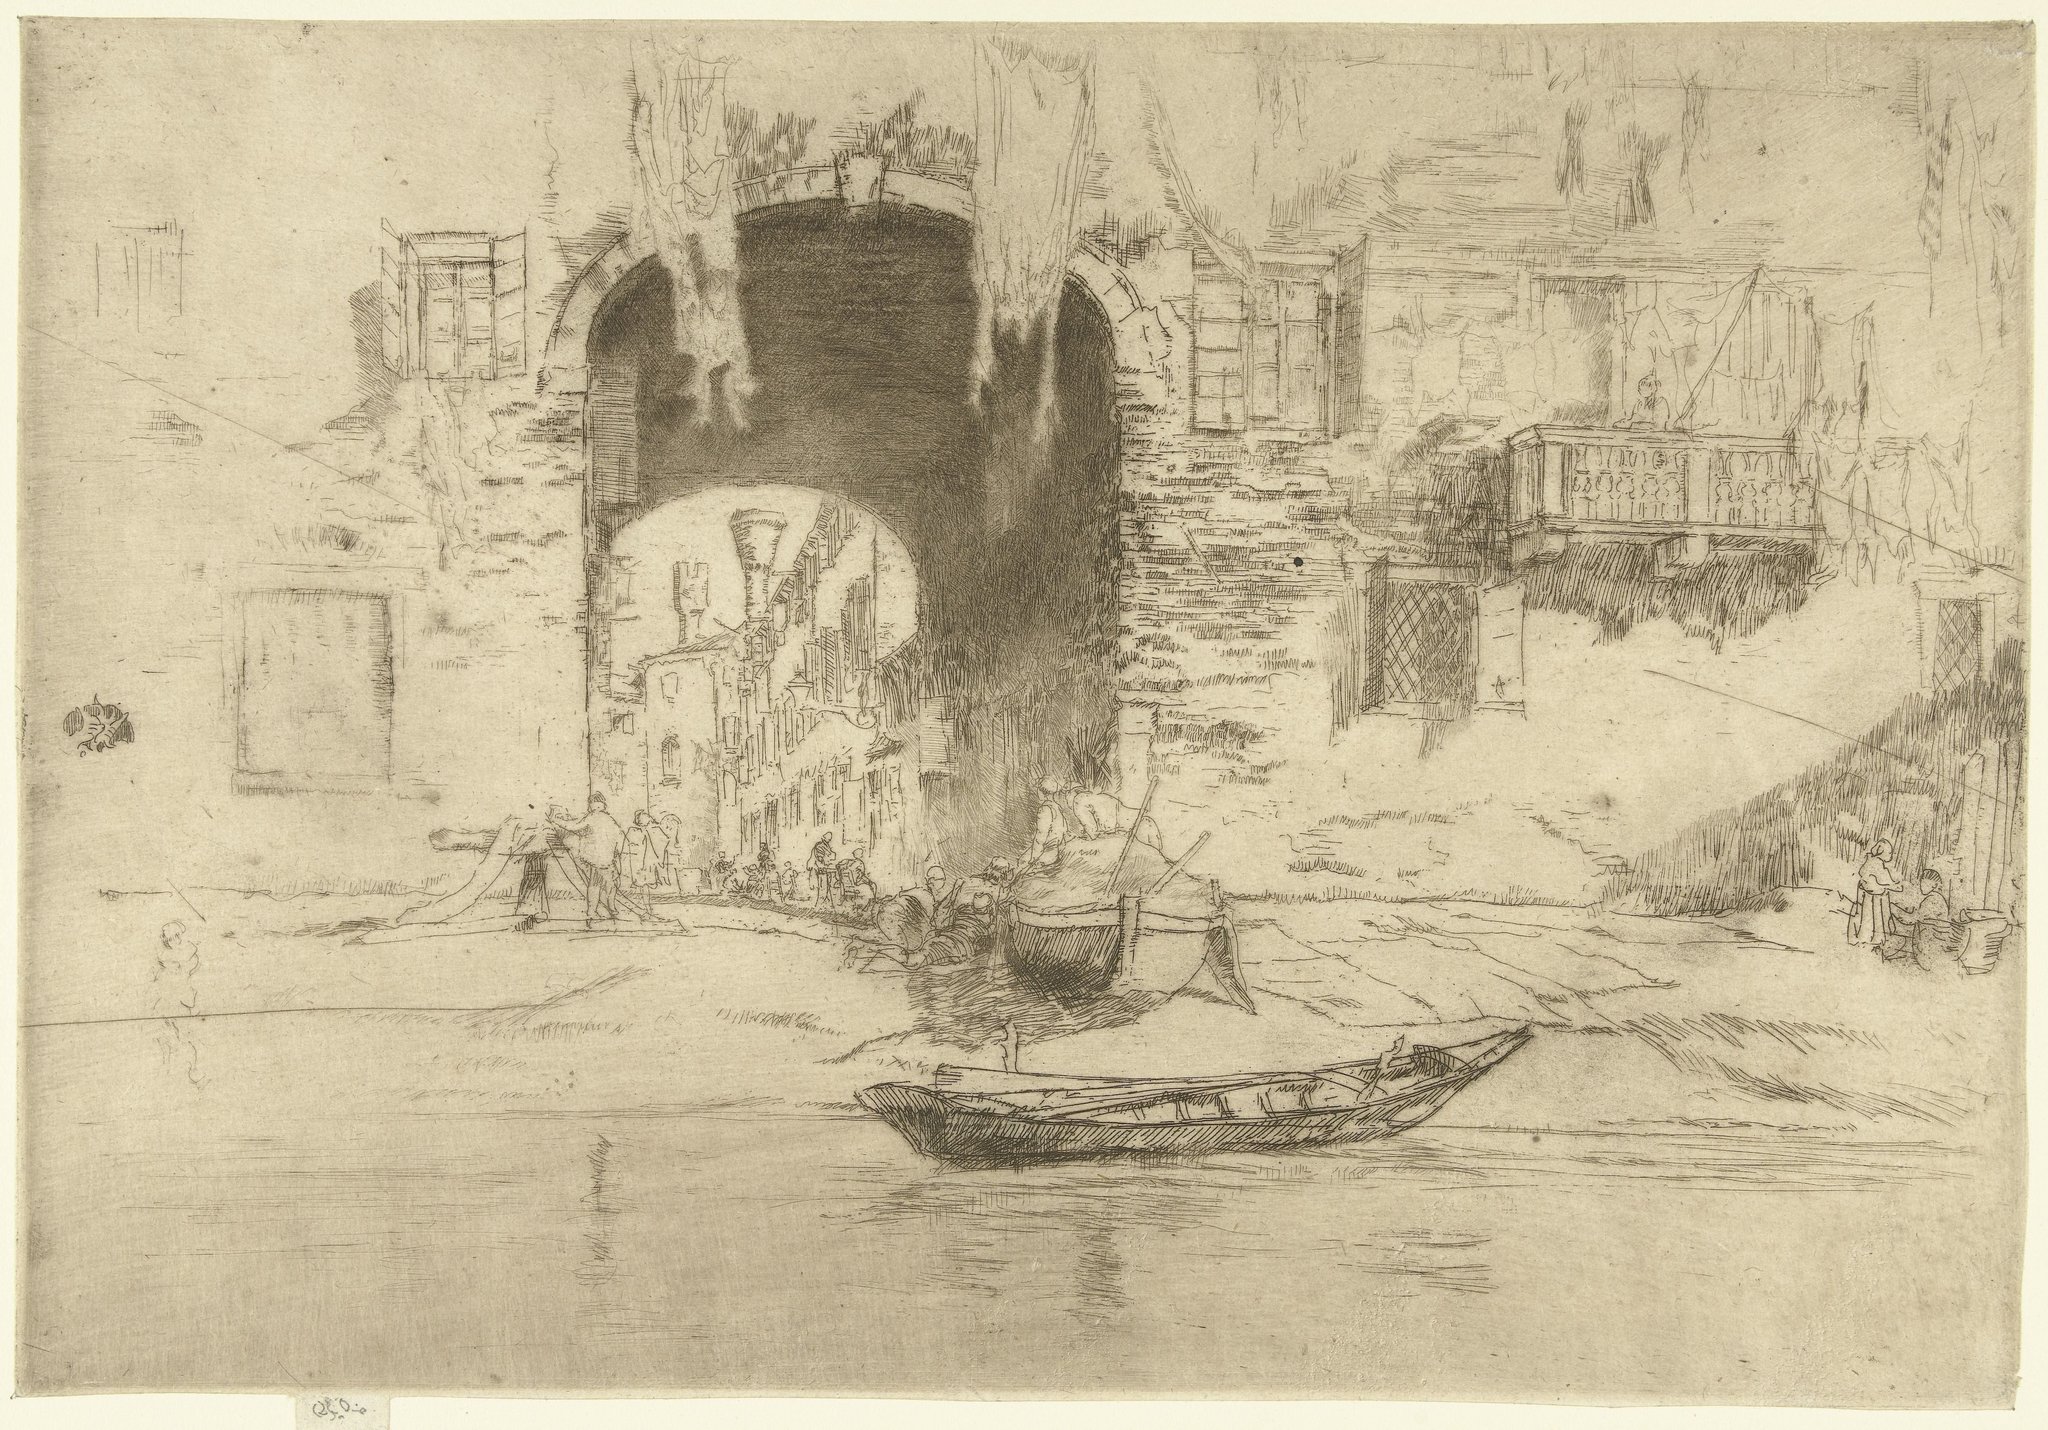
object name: print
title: San Biagio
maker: james abbott mcneill whistler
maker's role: painter, print maker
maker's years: 1834-1903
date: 1879-1880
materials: paper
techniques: drypoint, etching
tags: arch, archivolt ~ architecture, canals, waters (in city)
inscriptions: signature: ‘JW imp’, collector's mark: Lugt 2228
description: Deze prent was onderdeel van "A set of twenty-six etchings", uitgegeven door Dowdeswell in 1886 te Londen. Botke, K.